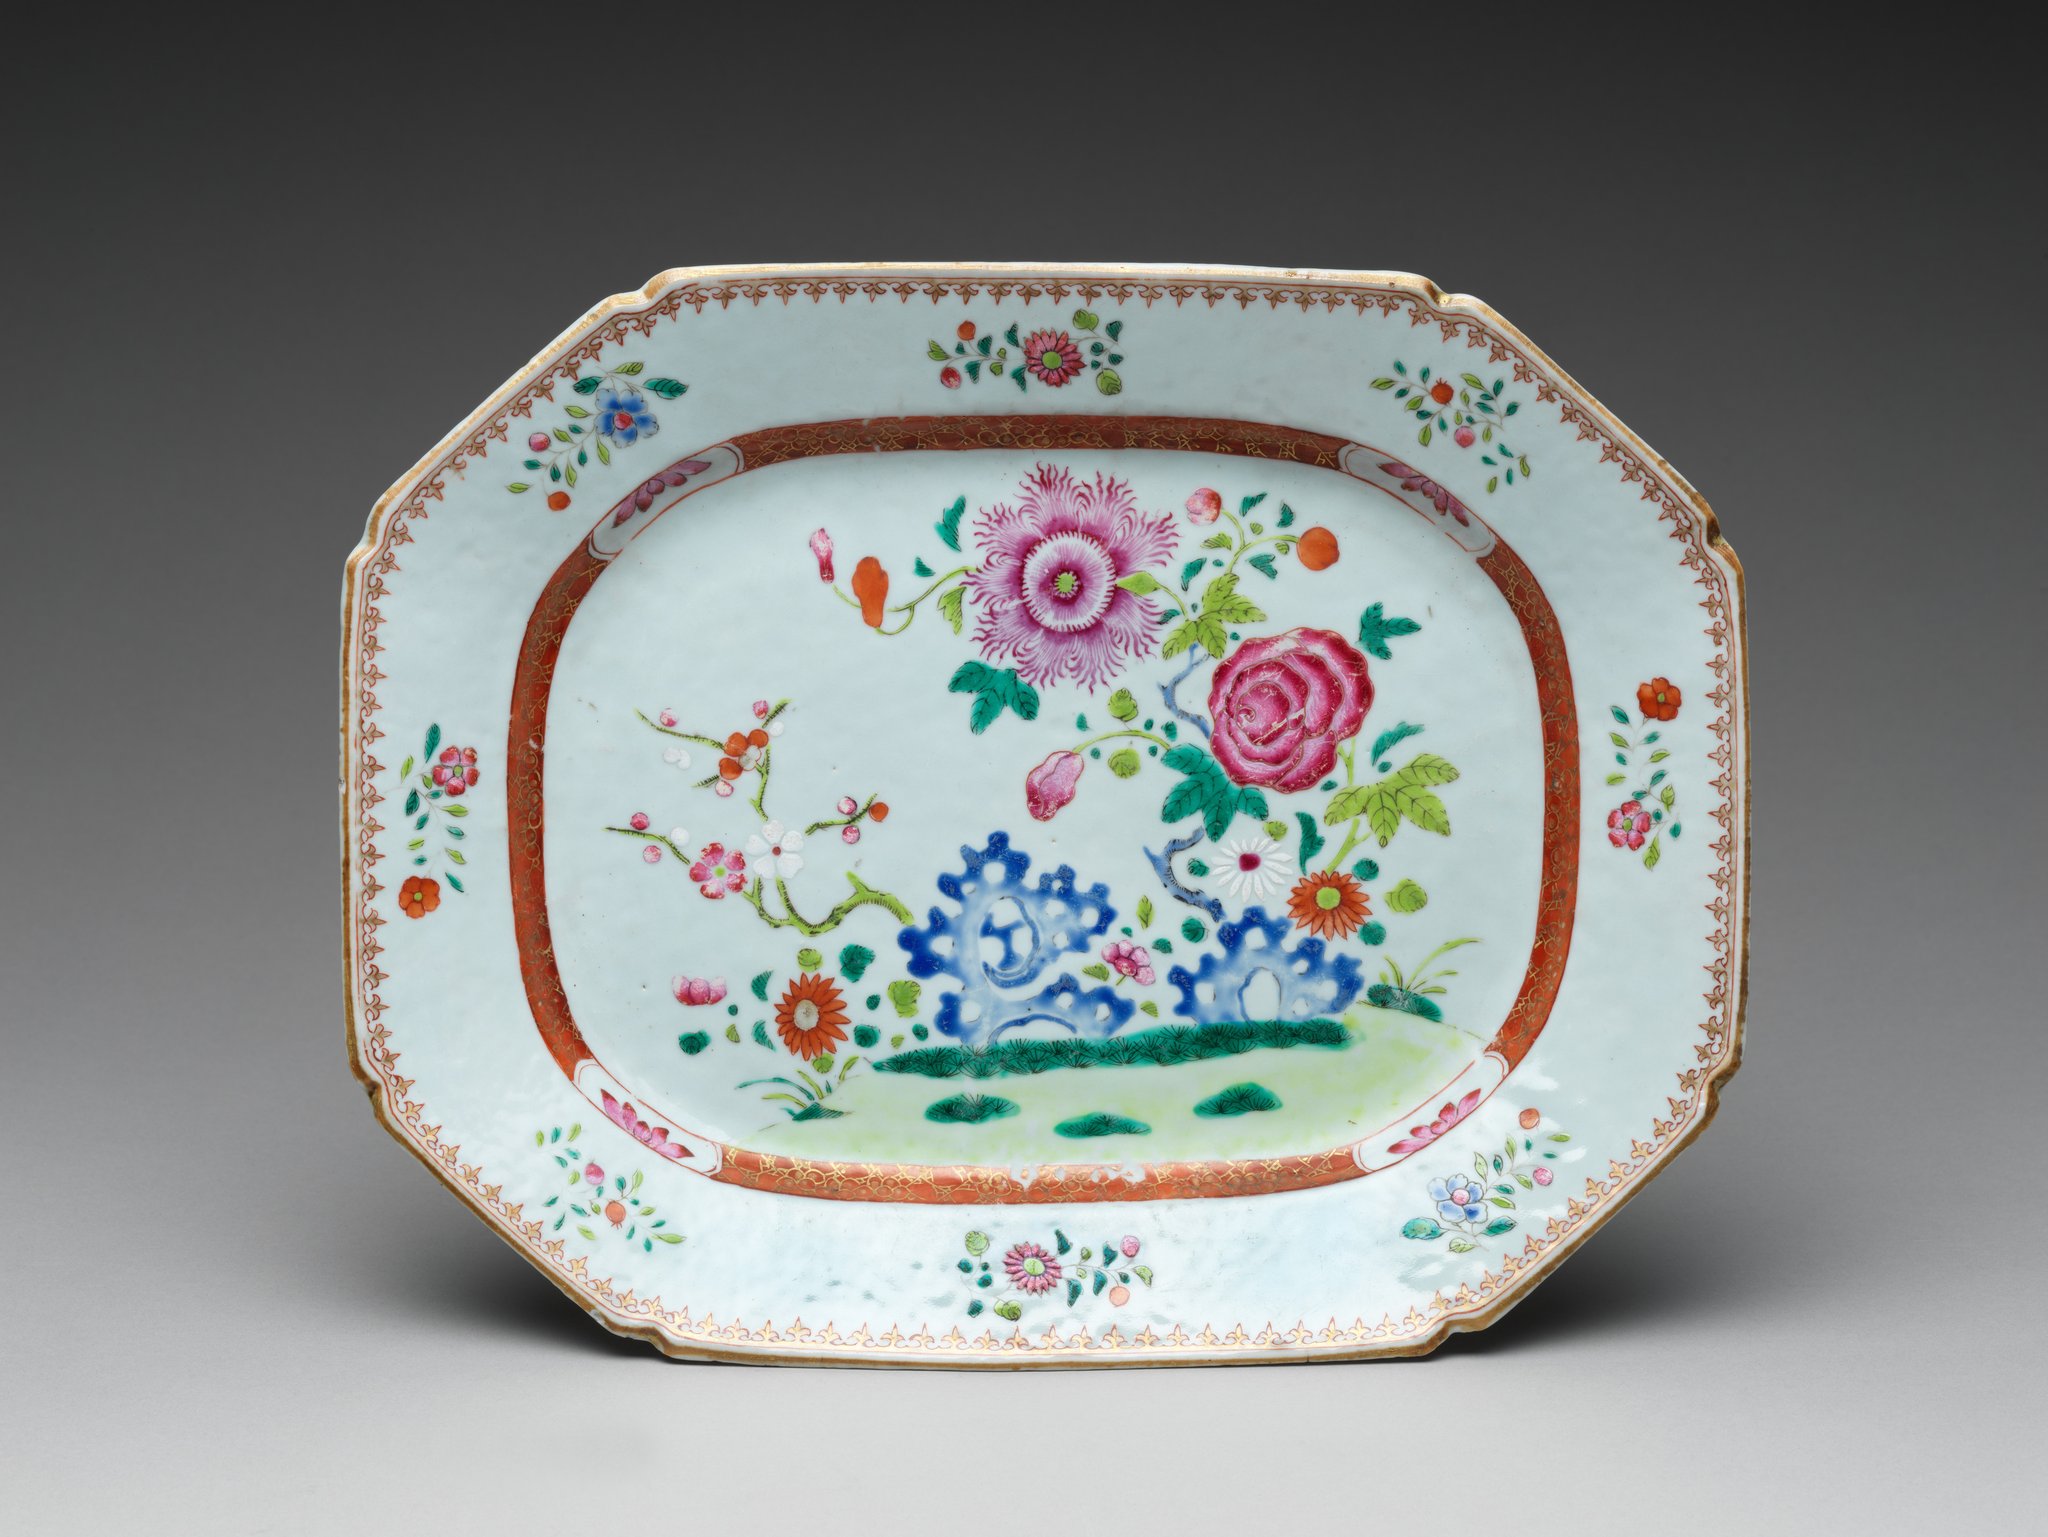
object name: platter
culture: chinese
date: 1765-1770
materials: porcelain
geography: china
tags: flowers